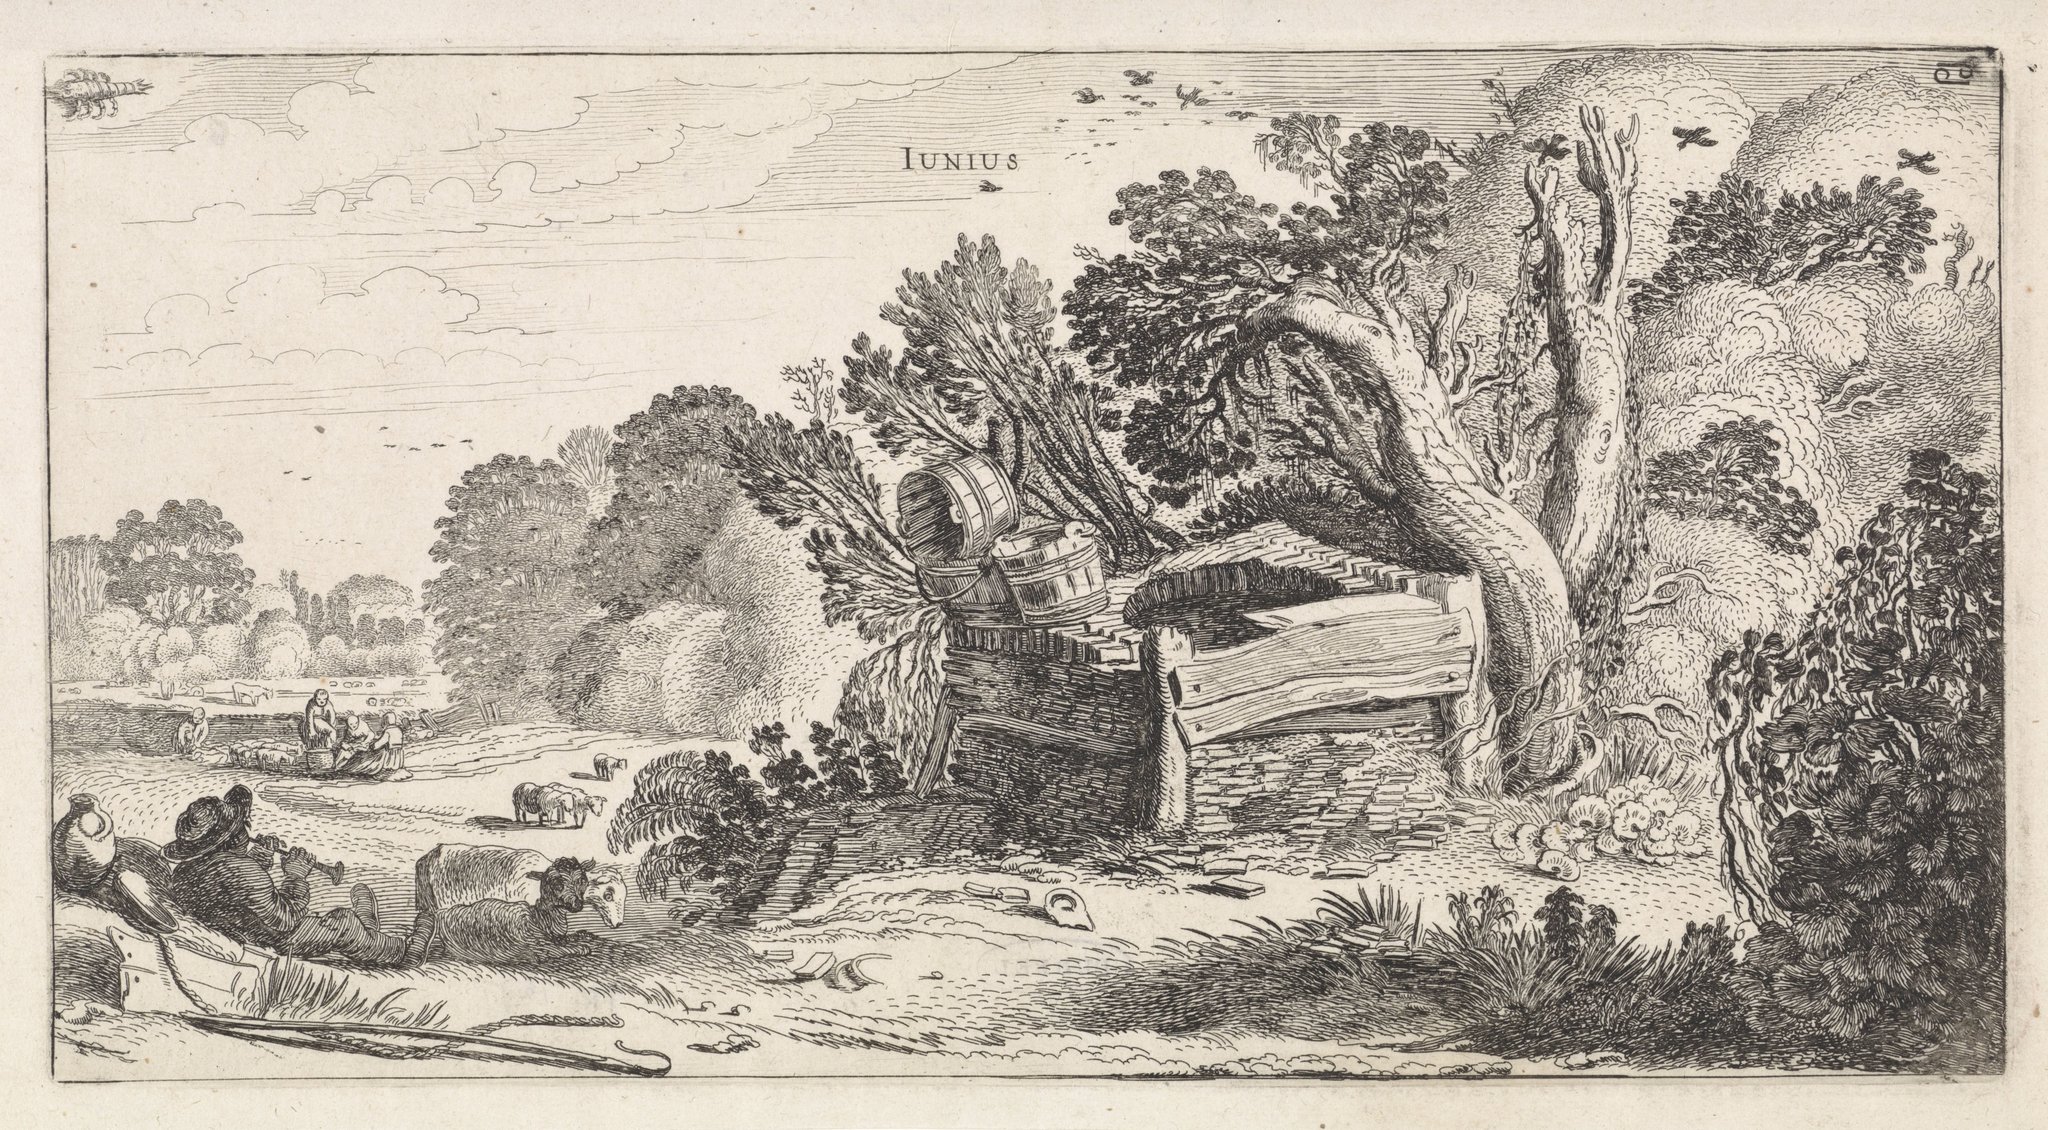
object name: print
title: De twaalf maanden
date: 1616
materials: paper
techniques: etching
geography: northern netherlands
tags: cancer (zodiacal sign of june), landscape symbolizing june, well, herding, herdsman, herdswoman, shepherd, shepherdess, cowherd, etc., flute, aulos, tibia - cc - out of doors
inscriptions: collector's mark: Lugt 2228, collector's mark: Lugt 240, collector's mark: Lugt 698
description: Een landschap met een een waterput, voorstellende de maand juni. Links een op een fluit spelende herder bij zijn kudde. Links- en rechtsboven de bij deze maand behorende symbolen van het sterrenbeeld kreeft. Zesde prent uit een serie van twaalf.